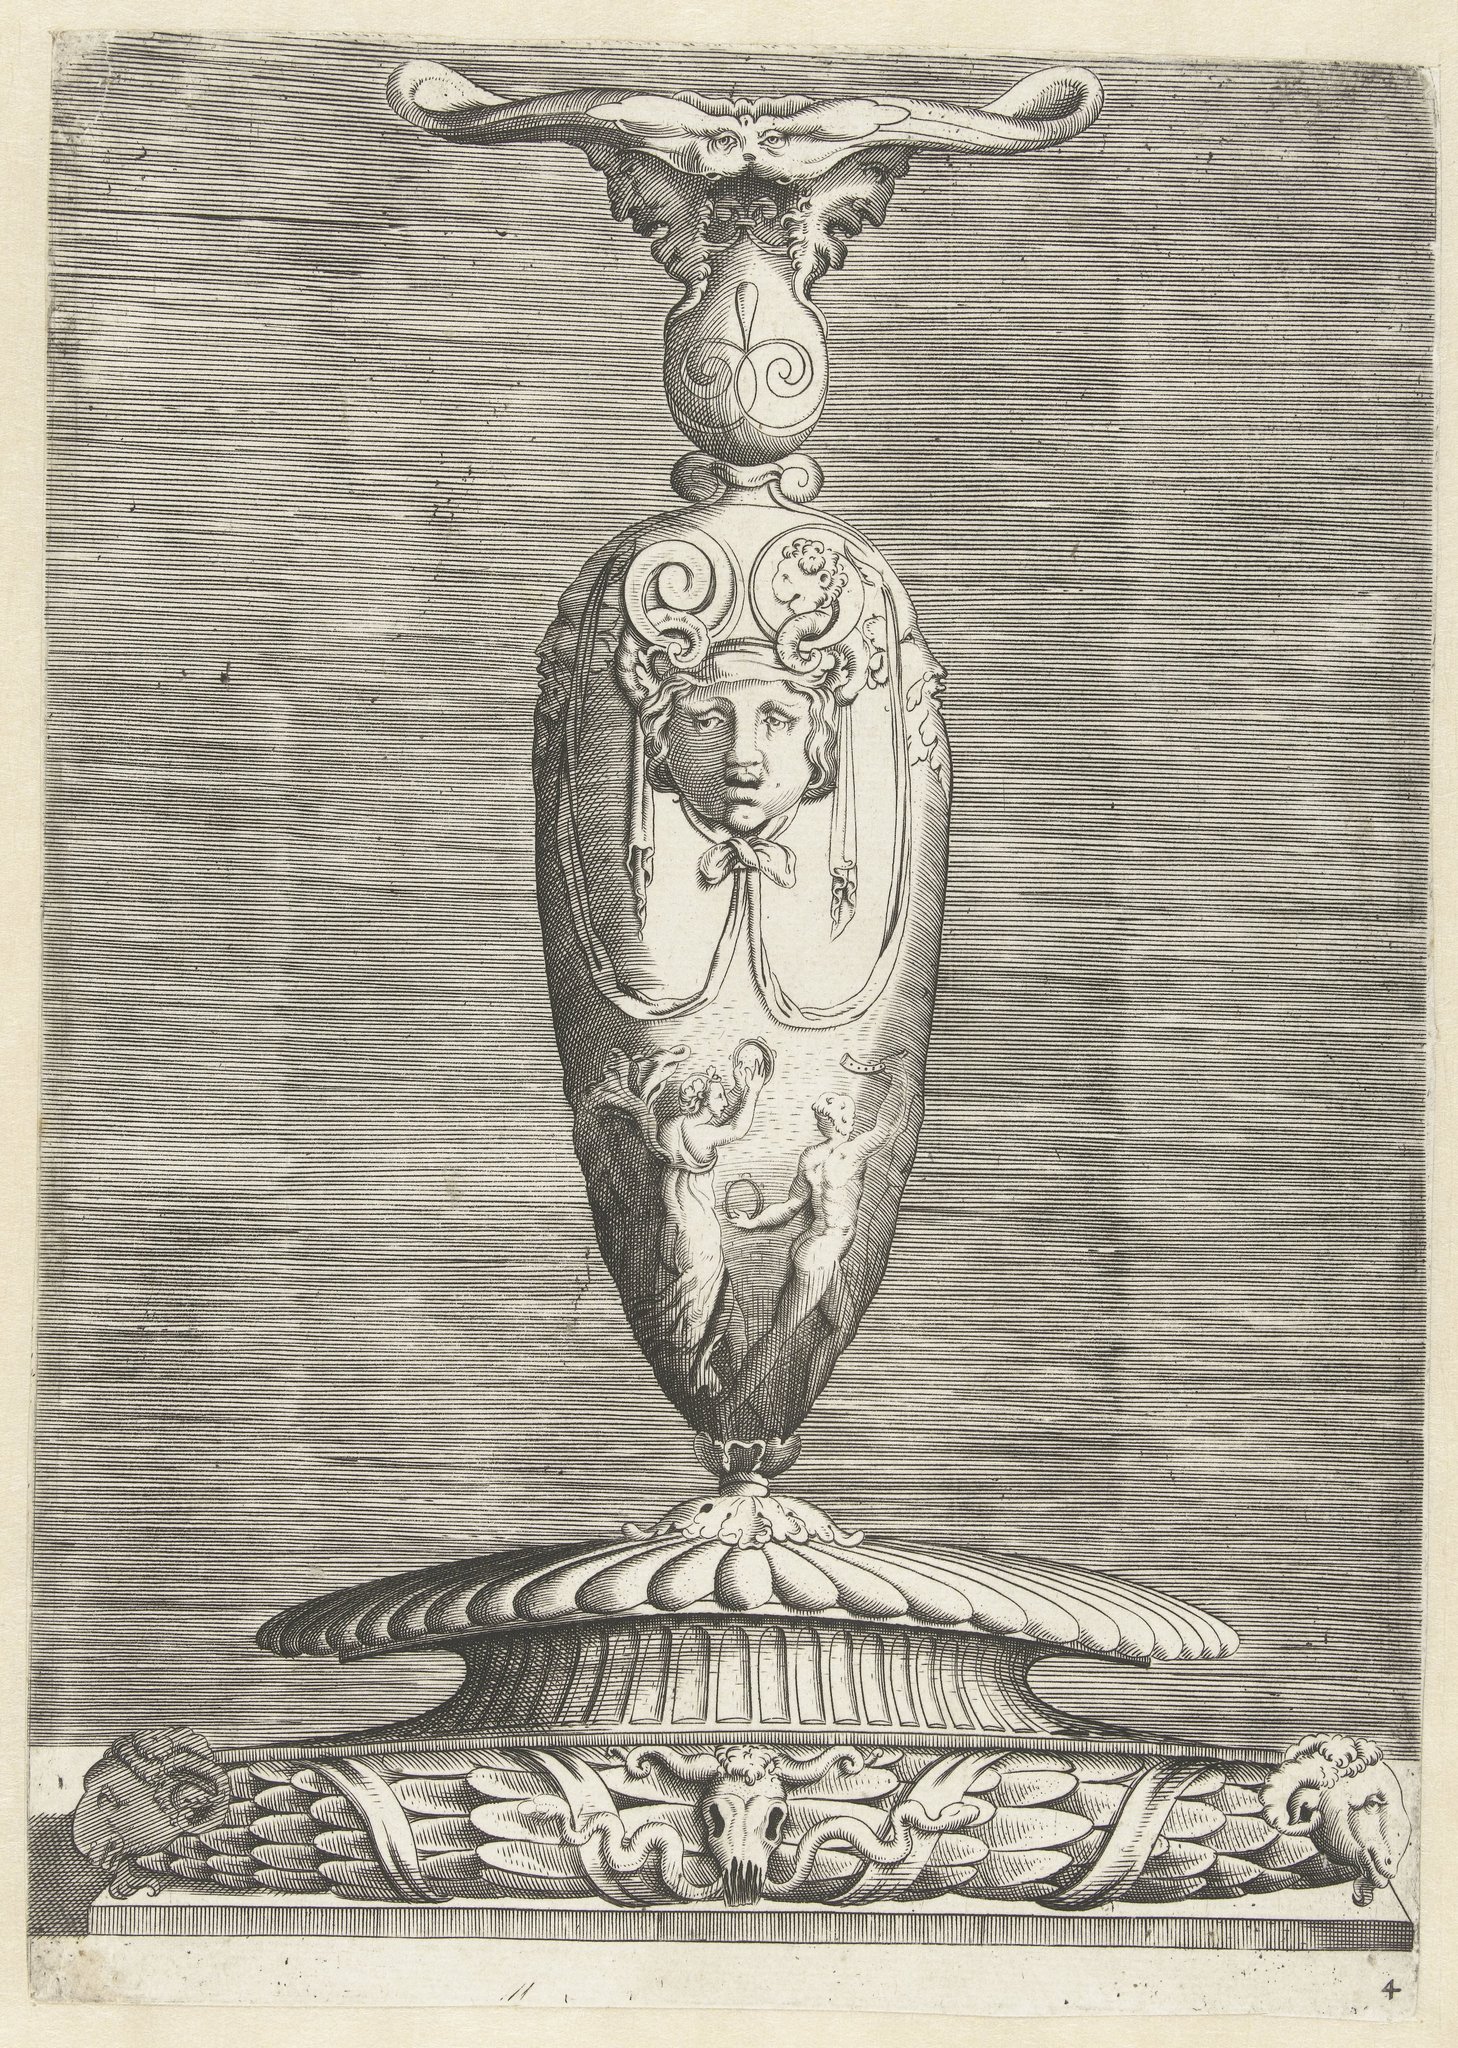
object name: print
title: Vaasvormige kandelaar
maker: Anonymous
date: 1552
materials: paper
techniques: engraving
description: De kandelaar is gedecoreerd met dansende mensen en een mascaron. Horizontaal gearceerde achtergrond. Tegenzijdige kopie naar door Enea Vico gegraveerde kandelaar.